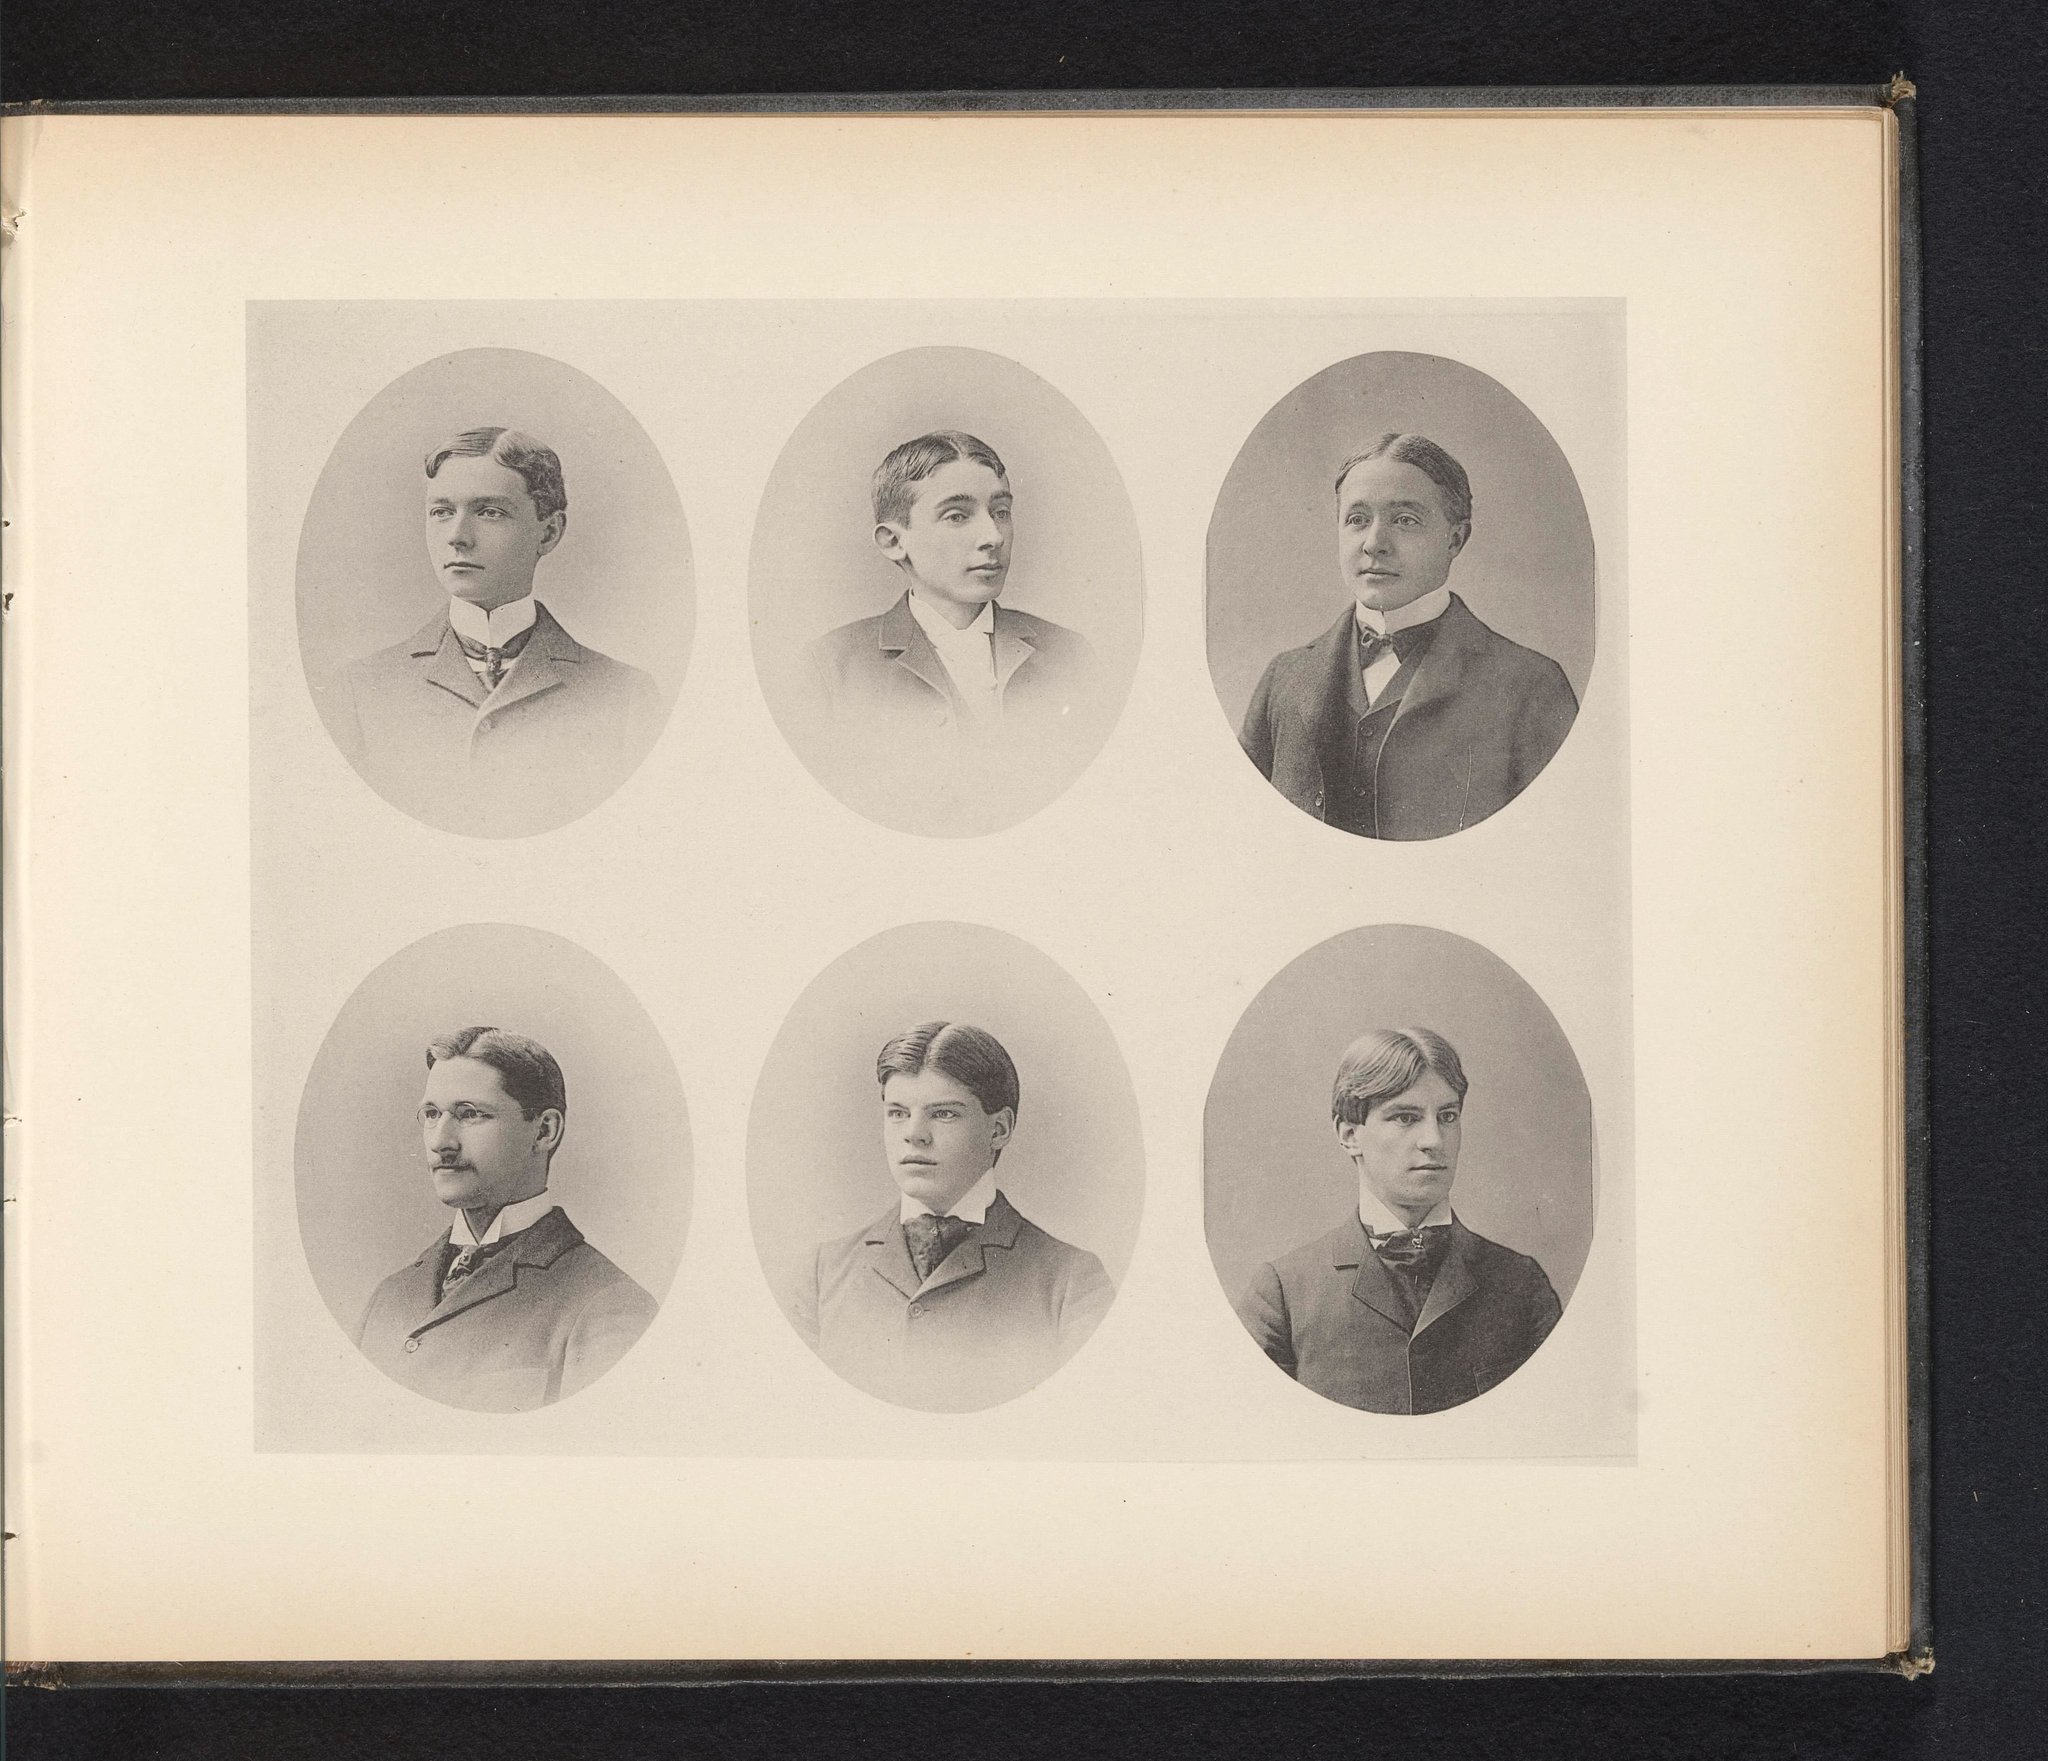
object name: photomechanical print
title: Zes portretten van afgestudeerde studenten van Yale University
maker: Anonymous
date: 1895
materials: paper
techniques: photograph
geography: new york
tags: student